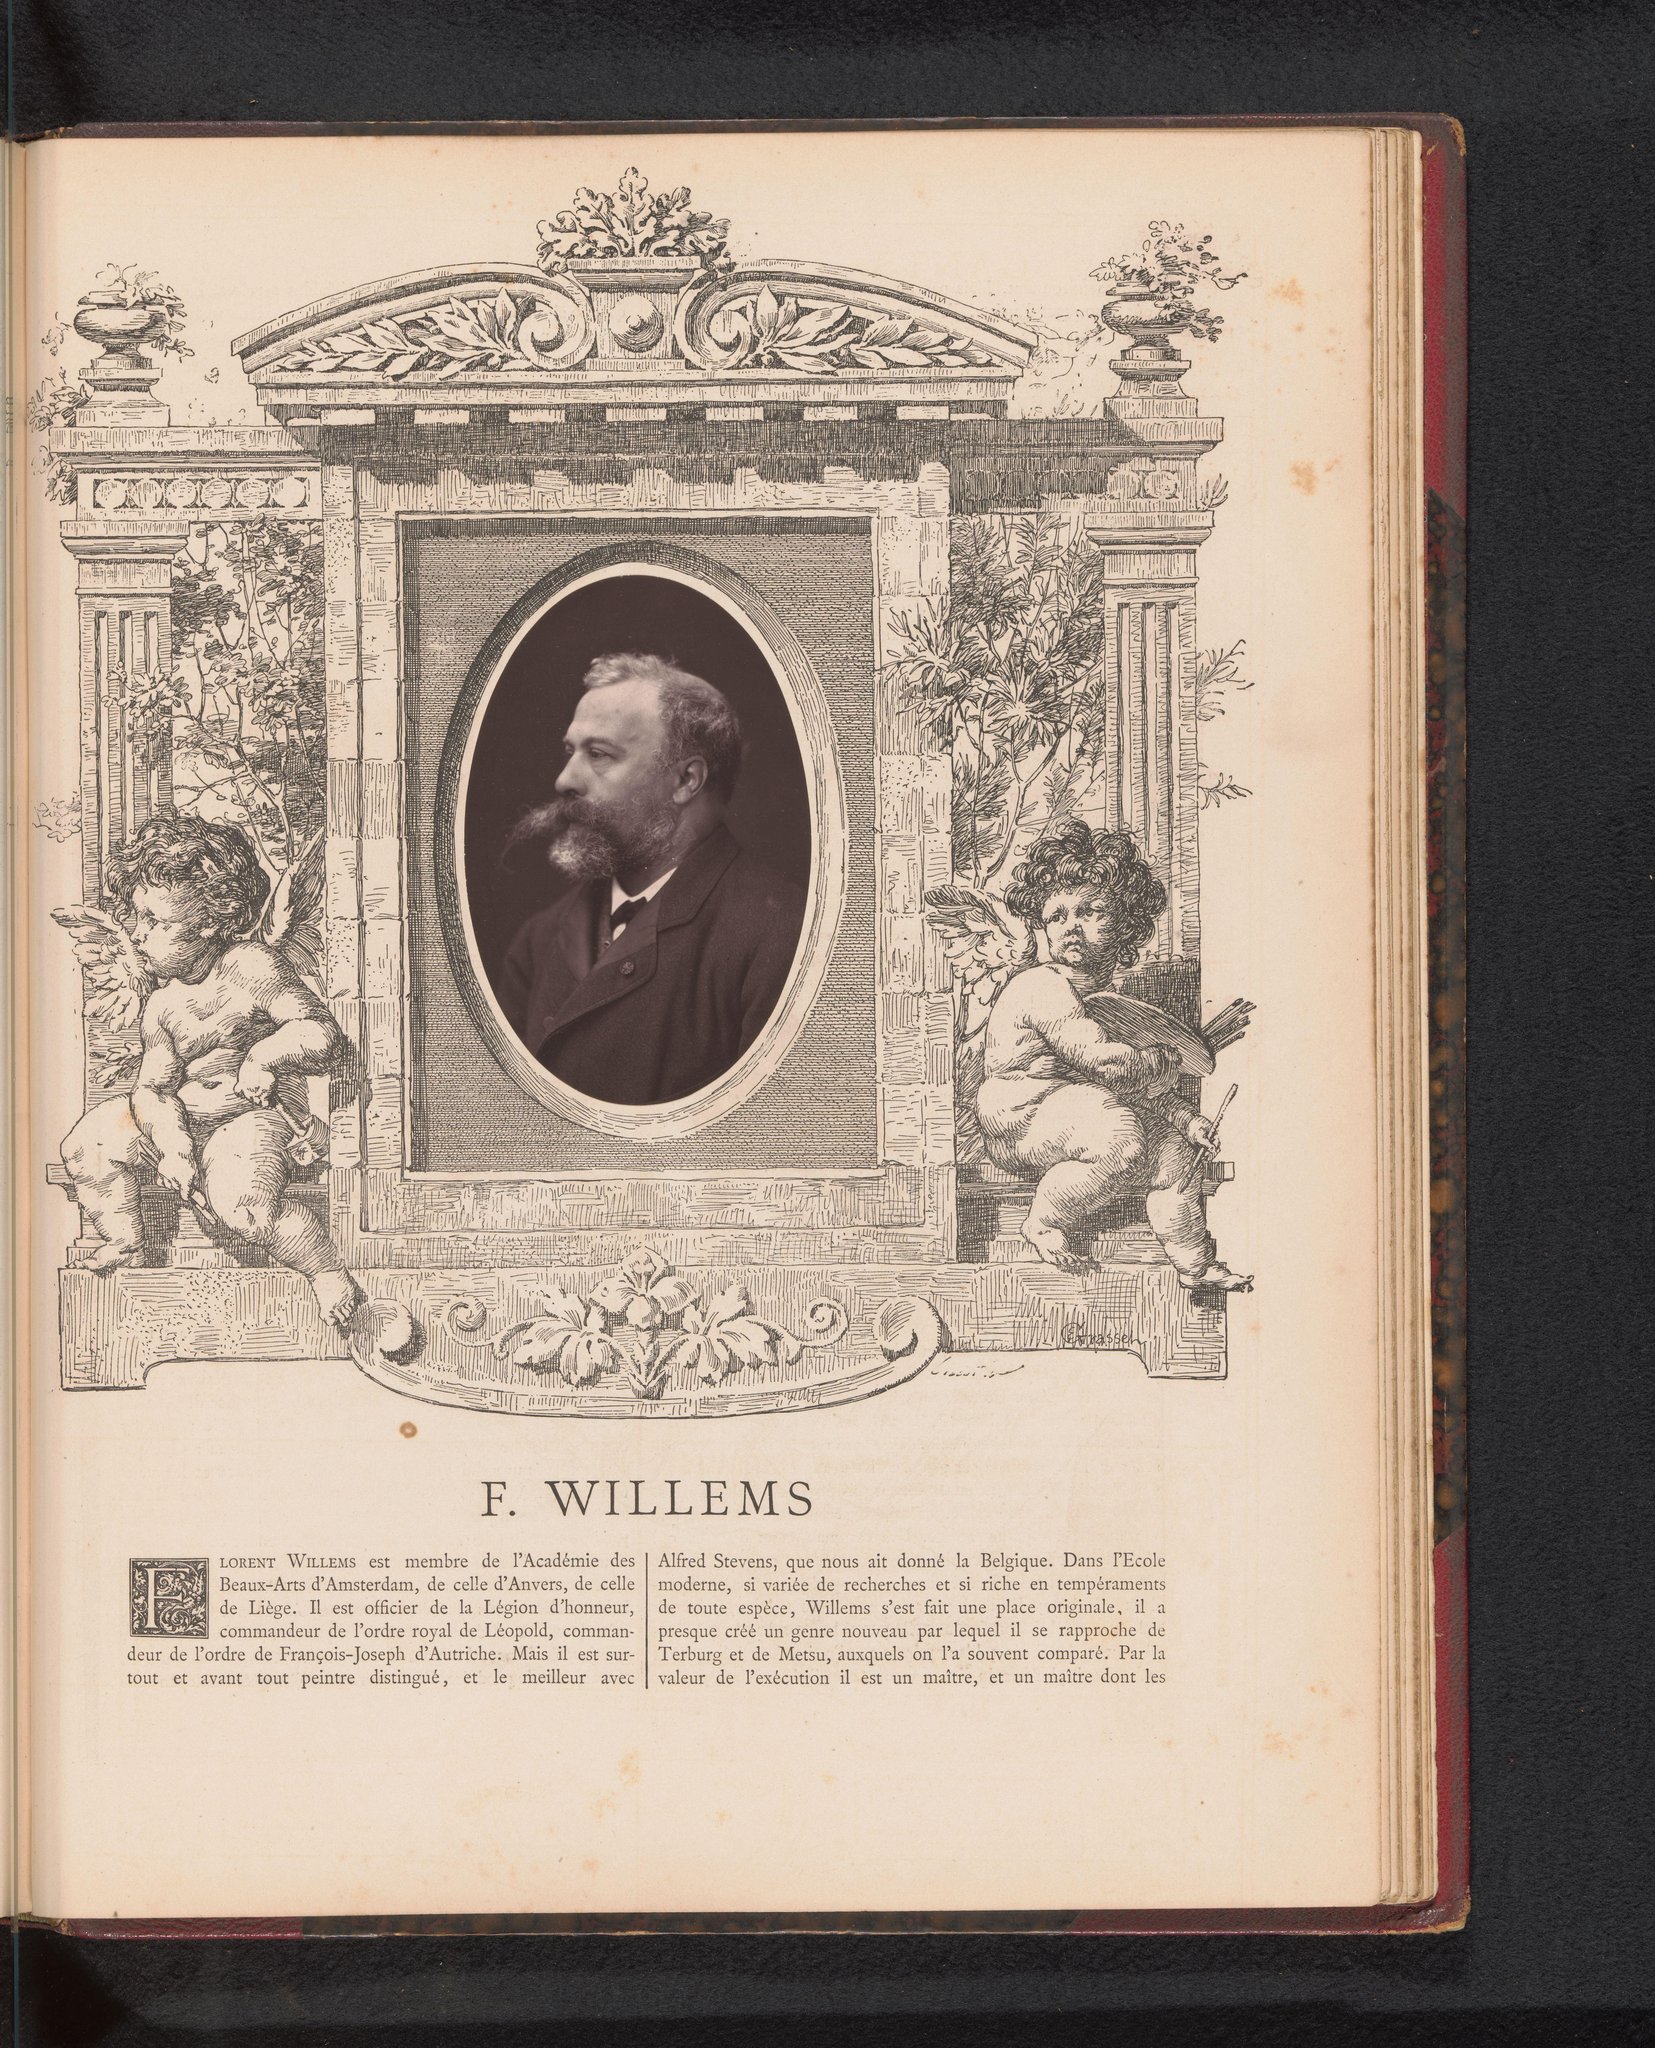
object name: page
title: Portret van Florent Willems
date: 1872-1877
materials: paper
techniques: printing block, woodburytype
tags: liège, florent willems, adult man, historical persons